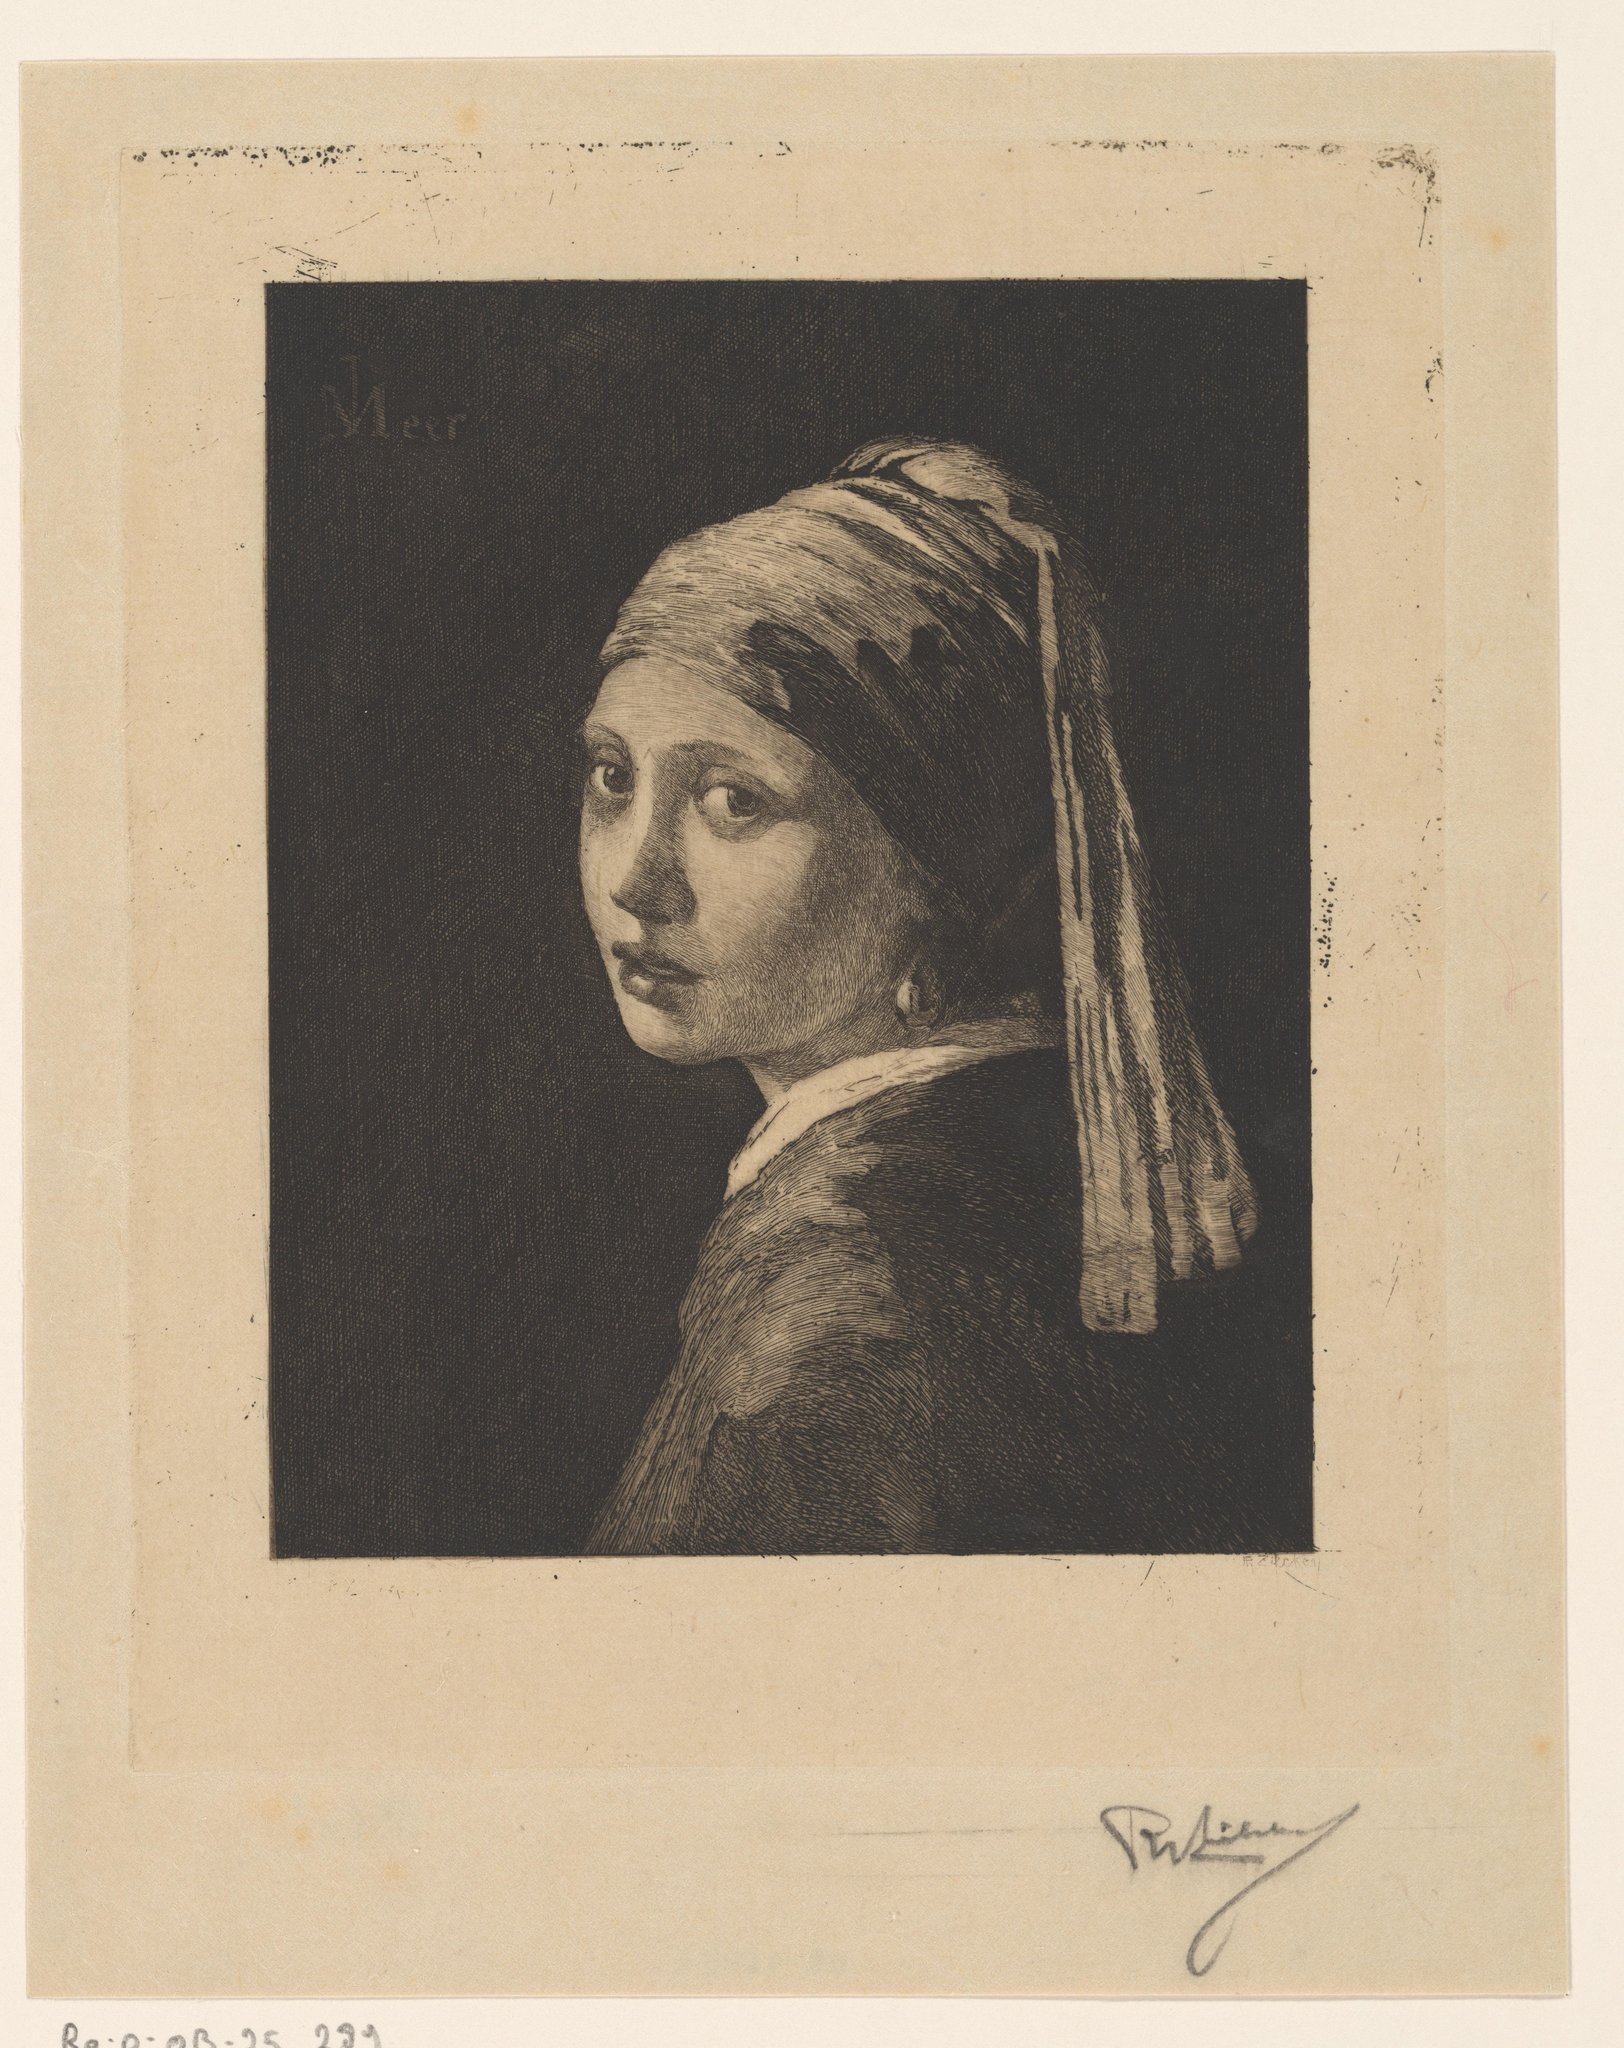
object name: print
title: Meisje met de parel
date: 1867-1890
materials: paper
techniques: drypoint, etching, intaglio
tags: girl (child between toddler and youth), pearl; pearl necklace, ear-rings